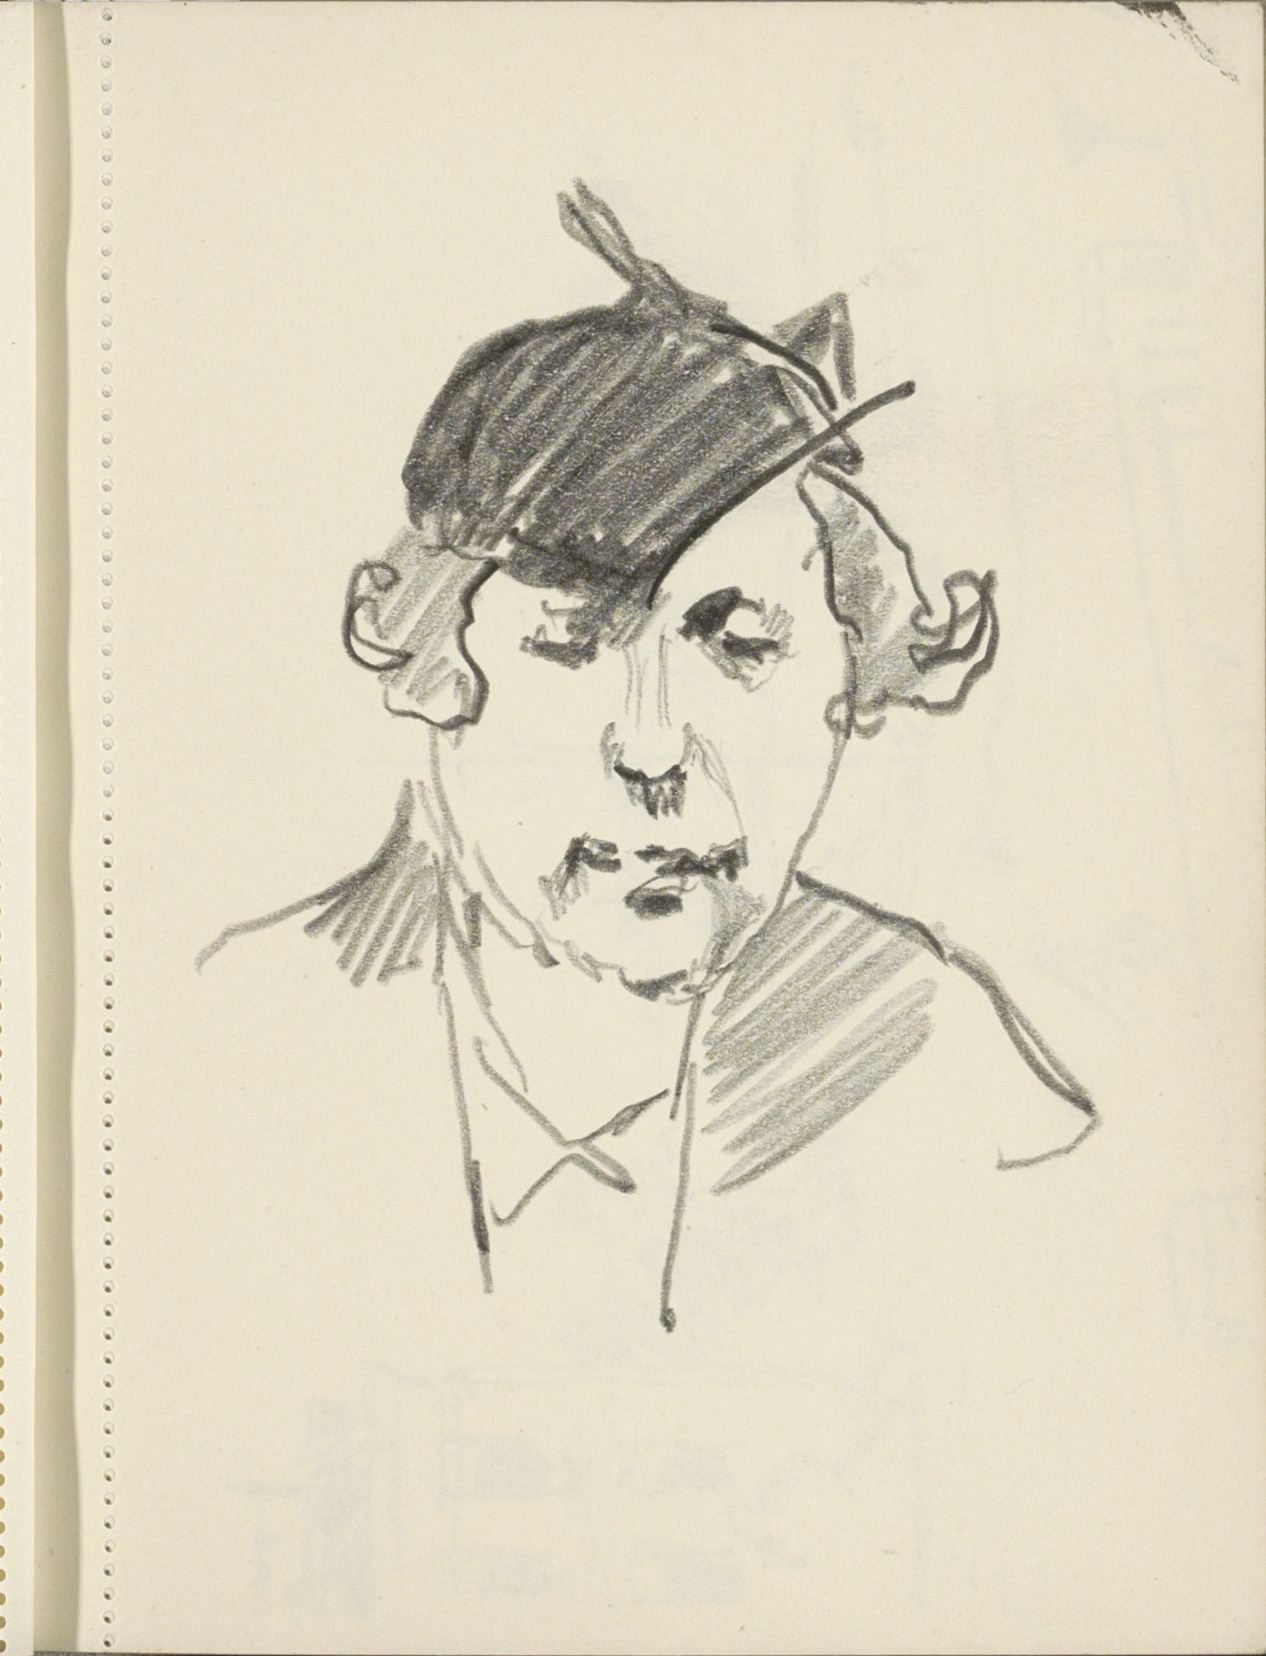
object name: sketchbook leaf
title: Portret van een vrouw met een hoed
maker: cornelis vreedenburgh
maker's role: draughtsman, print maker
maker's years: 1880-1946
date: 1890-1946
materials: paper, pencil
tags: adult woman, head-gear: hat (+ women's clothes)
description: Blad 38 recto uit een schetsboek met 71 bladen.